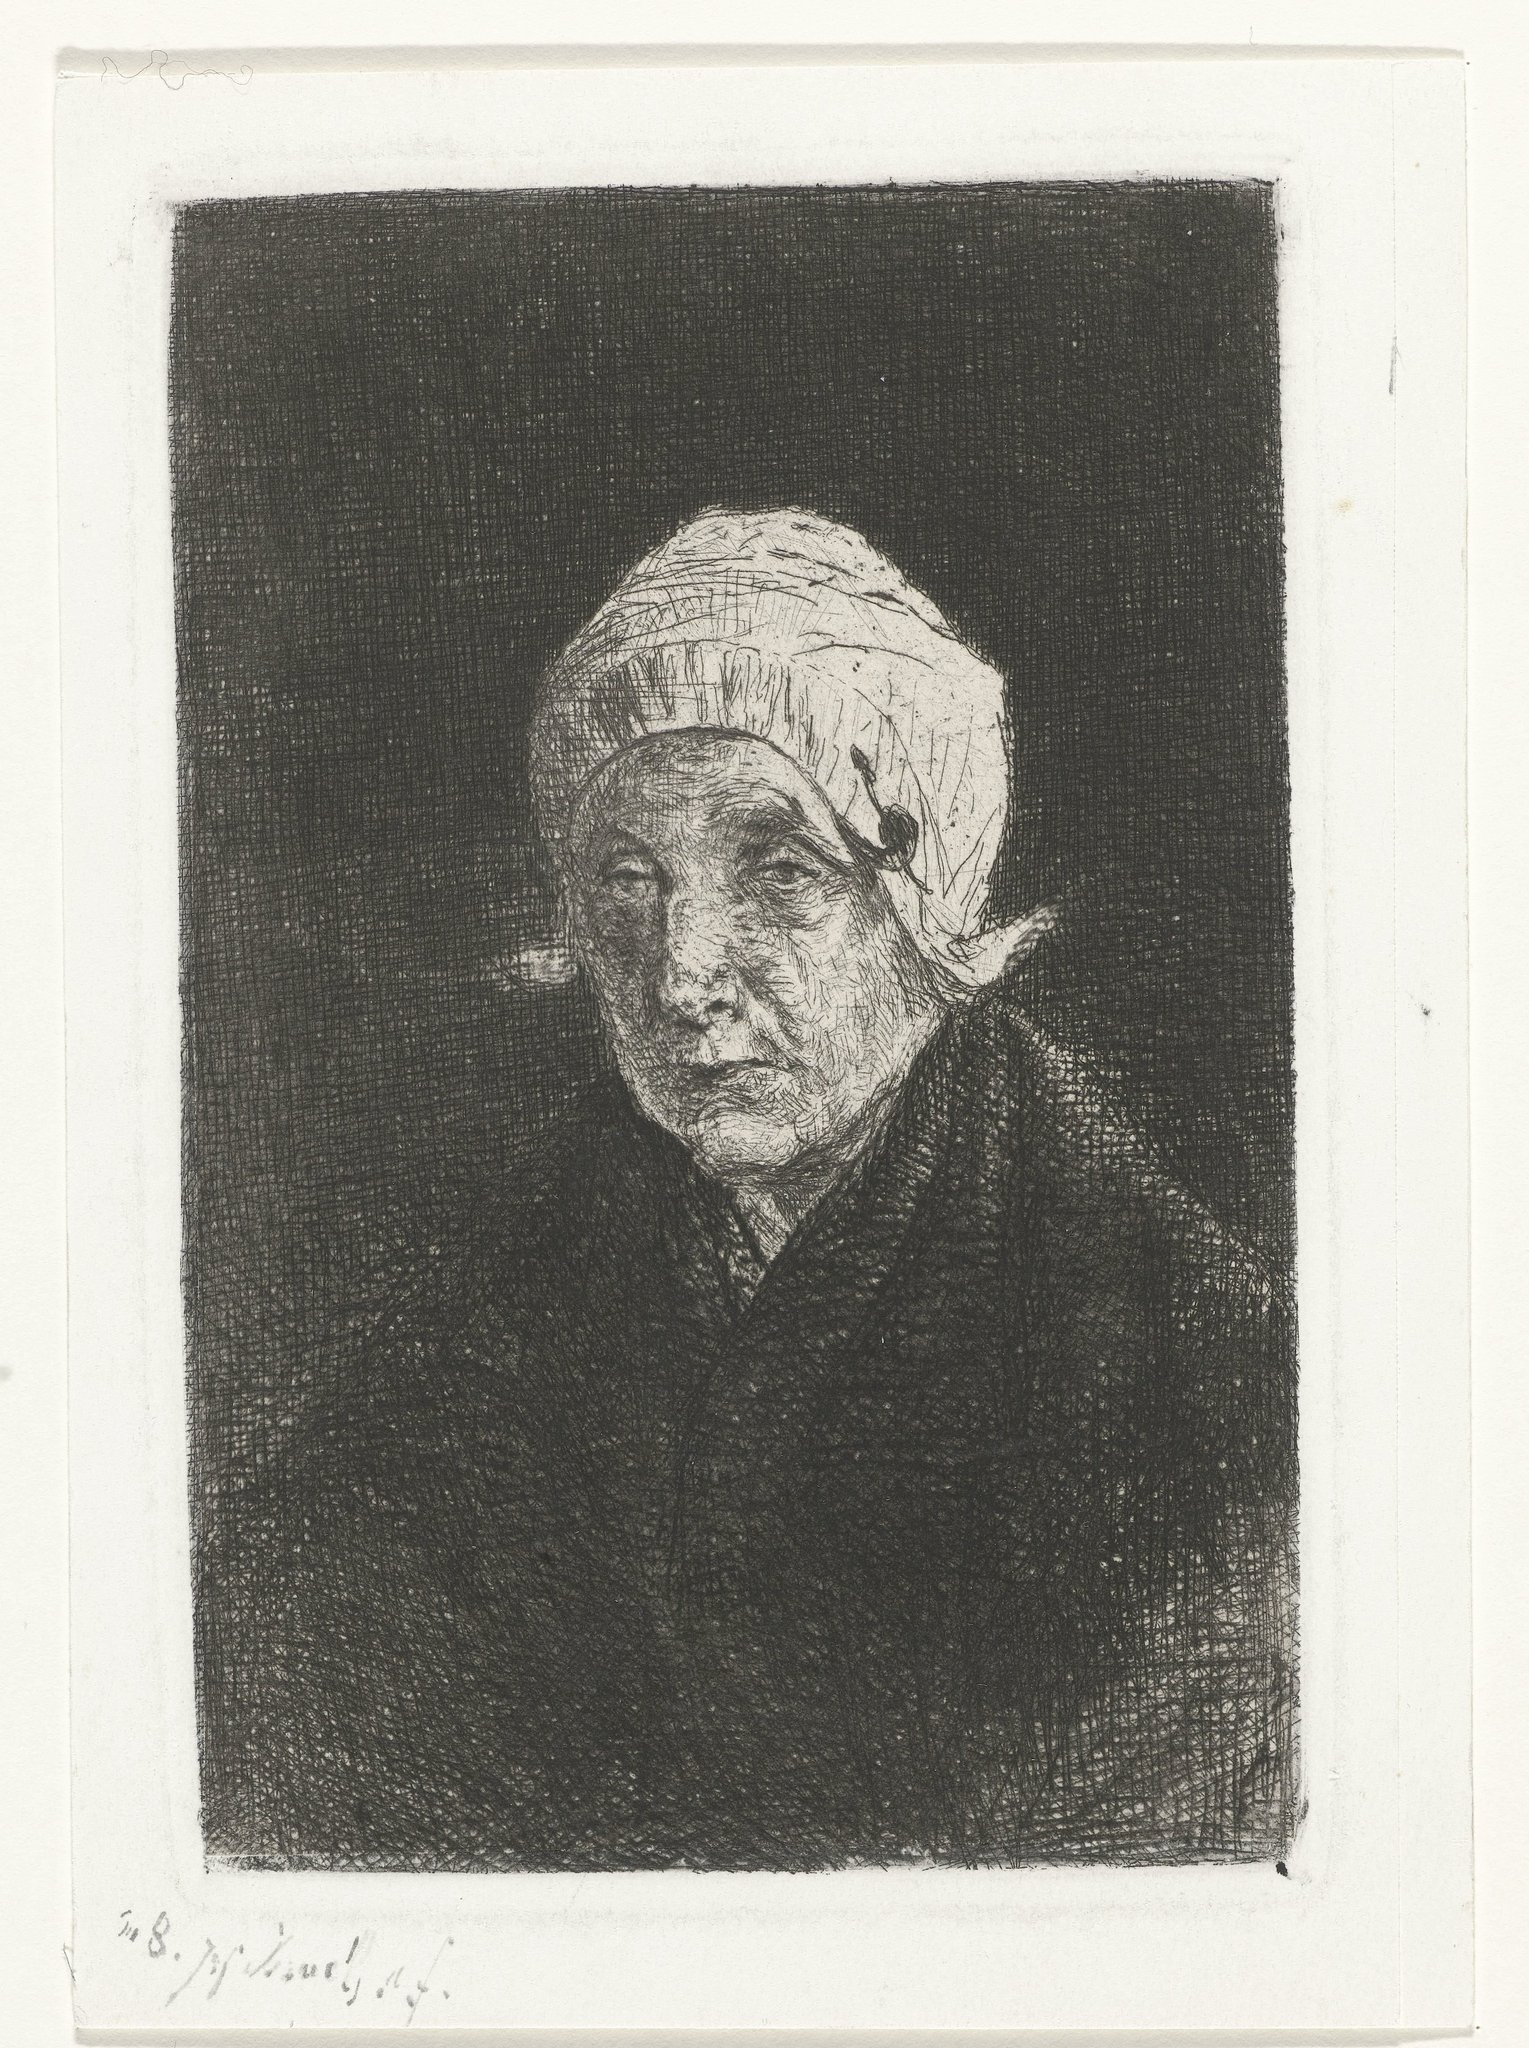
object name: print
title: Katwijkse oude vrouw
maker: jozef israëls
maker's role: draughtsman, painter, print maker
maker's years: 1824-1911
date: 1834-1878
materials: paper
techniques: etching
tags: old woman, chest, bust - aa - female human figure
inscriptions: inscription: ‘In B. Jzf Israels a.f.’, collector's mark: Lugt 2228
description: Buste van een Katwijkse oude vrouw, licht naar links.